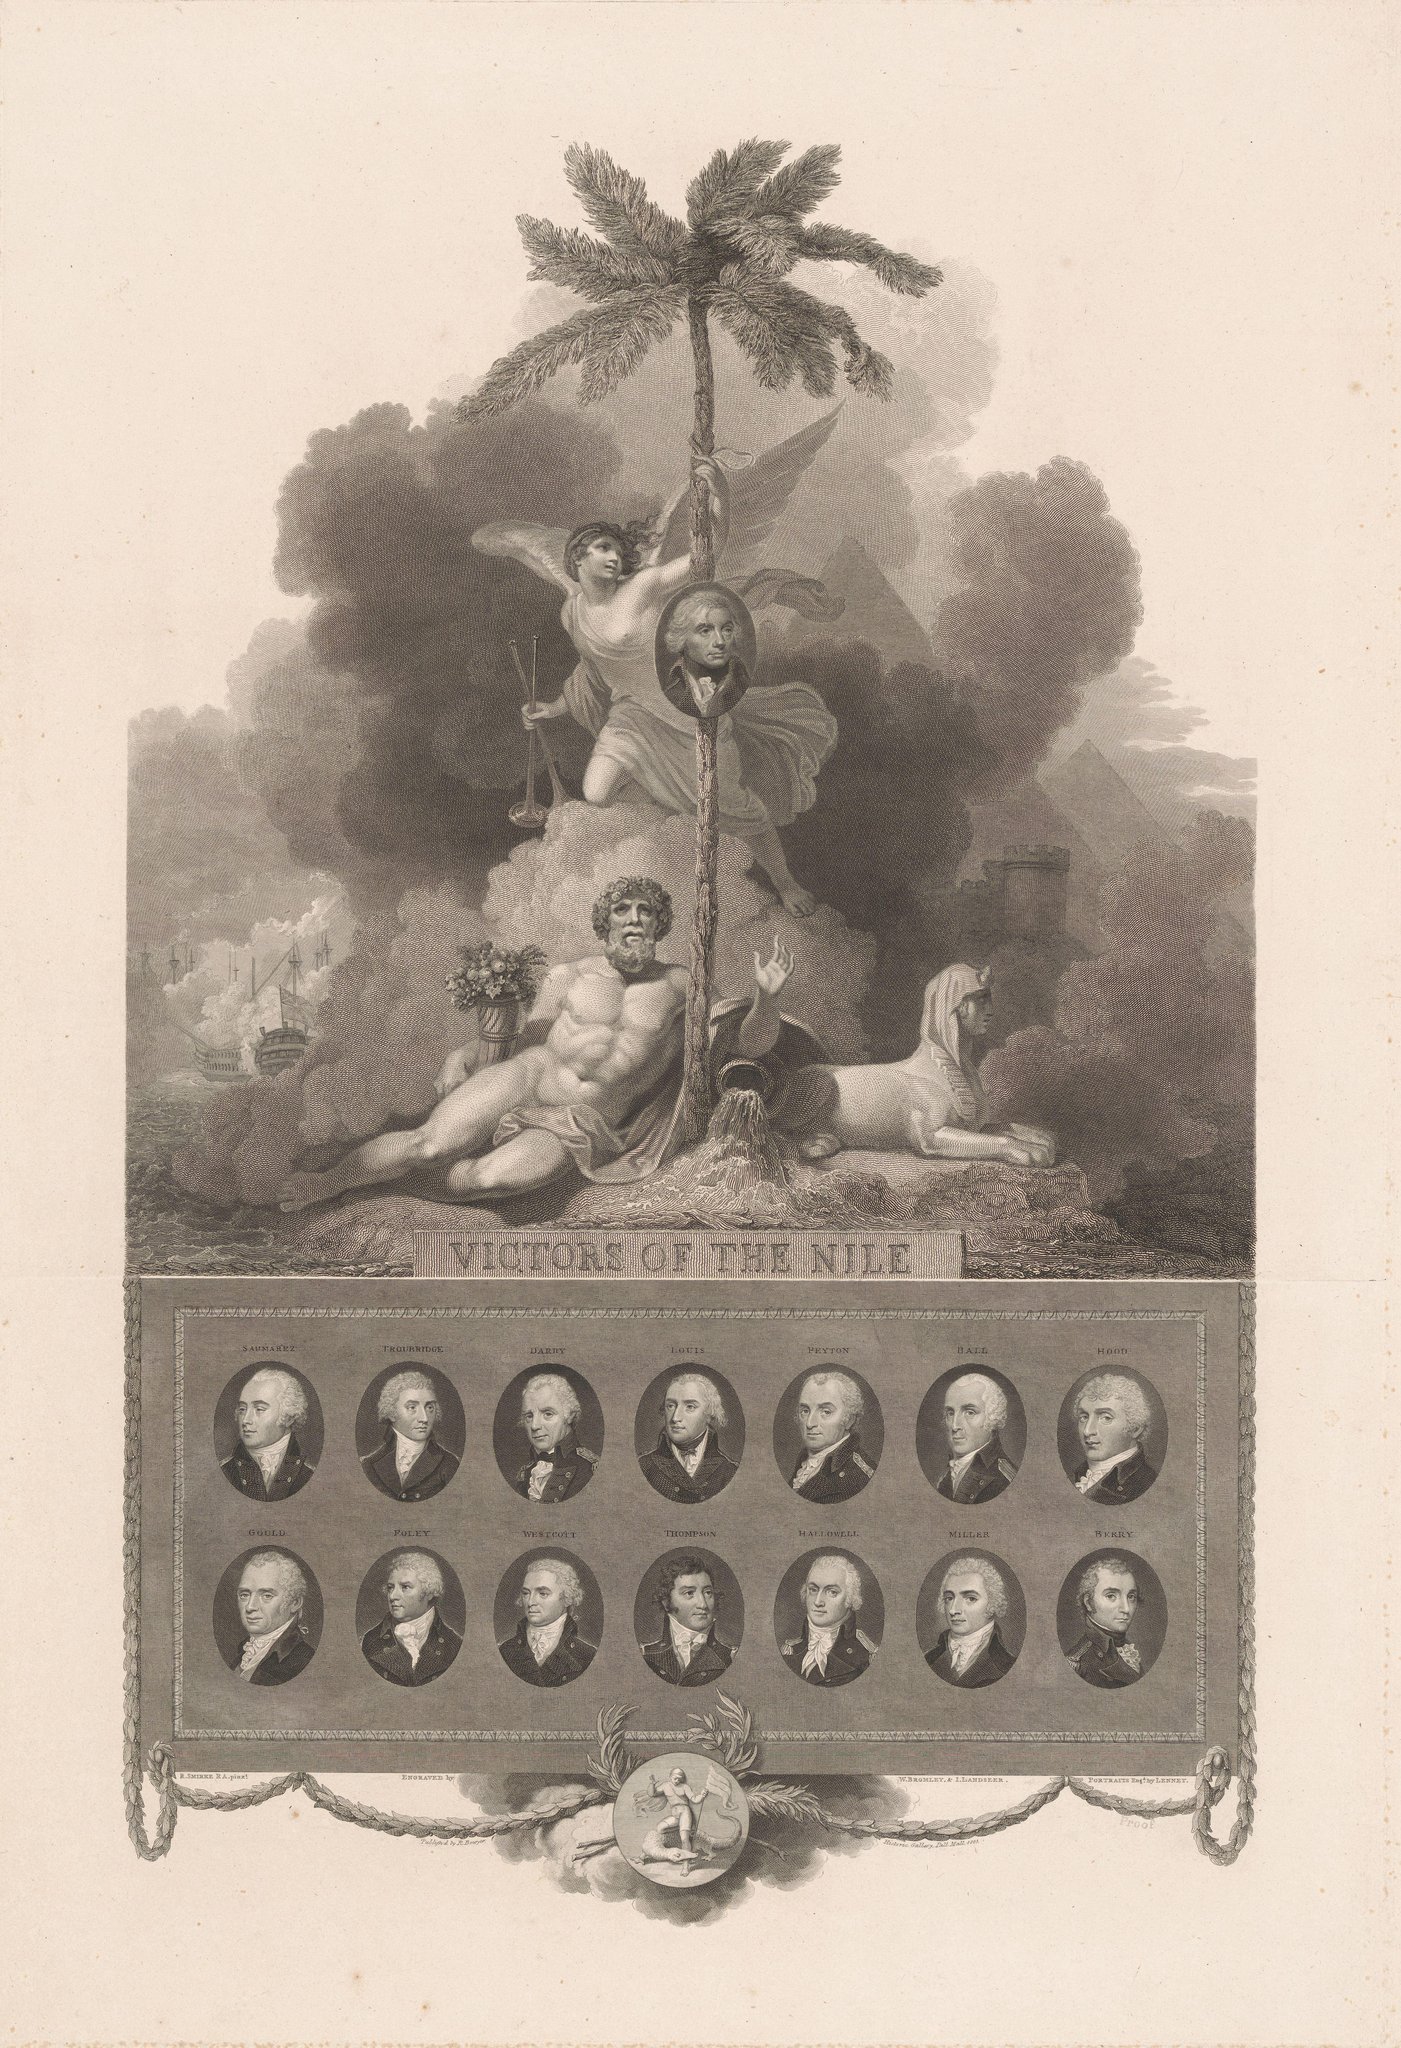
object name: print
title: Vier Engelse overwinningen op zee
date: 1803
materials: paper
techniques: engraving, etching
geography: england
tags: horatio nelson (hertog van bronte), new york (city), historical persons, trees: palm-tree, fame; 'fama', 'fama buona', 'fama chiara' (ripa), personification of river nile; 'nilo' (ripa)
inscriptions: collector's mark: Lugt 12